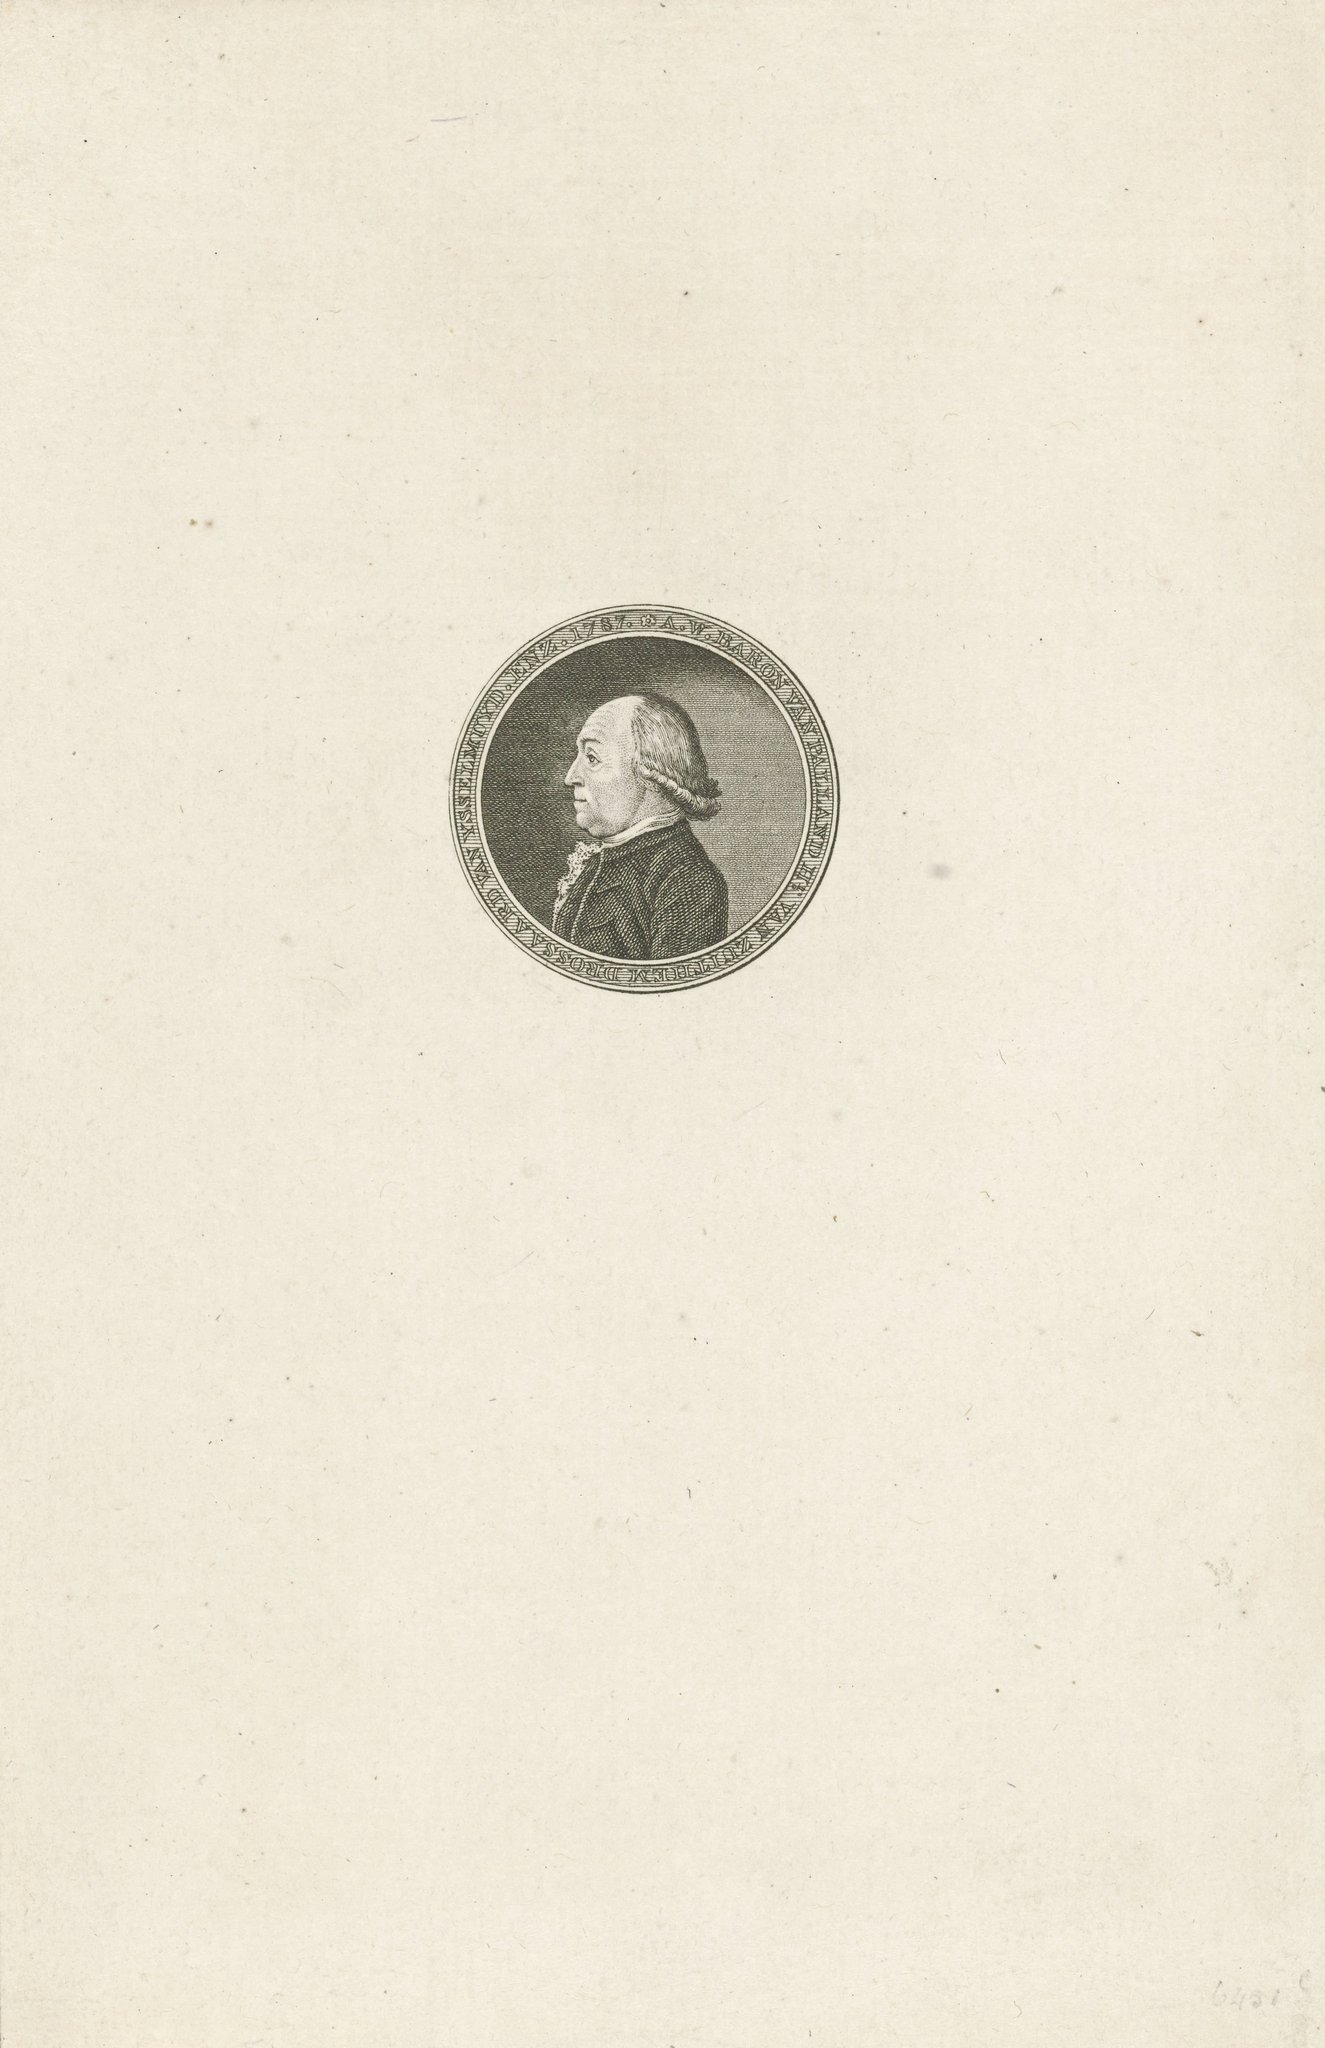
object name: print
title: Portret van Adolph Werner van Pallandt tot Zuthem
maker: abraham jacobsz. hulk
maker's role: print maker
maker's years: 1751-1817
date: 1787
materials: paper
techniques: engraving, etching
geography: paris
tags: historical persons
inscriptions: collector's mark: Lugt 2228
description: Buste van Adolph Werner van Pallandt tot Zuthem en profil naar links in een medaillon met randschrift in het Nederlands.